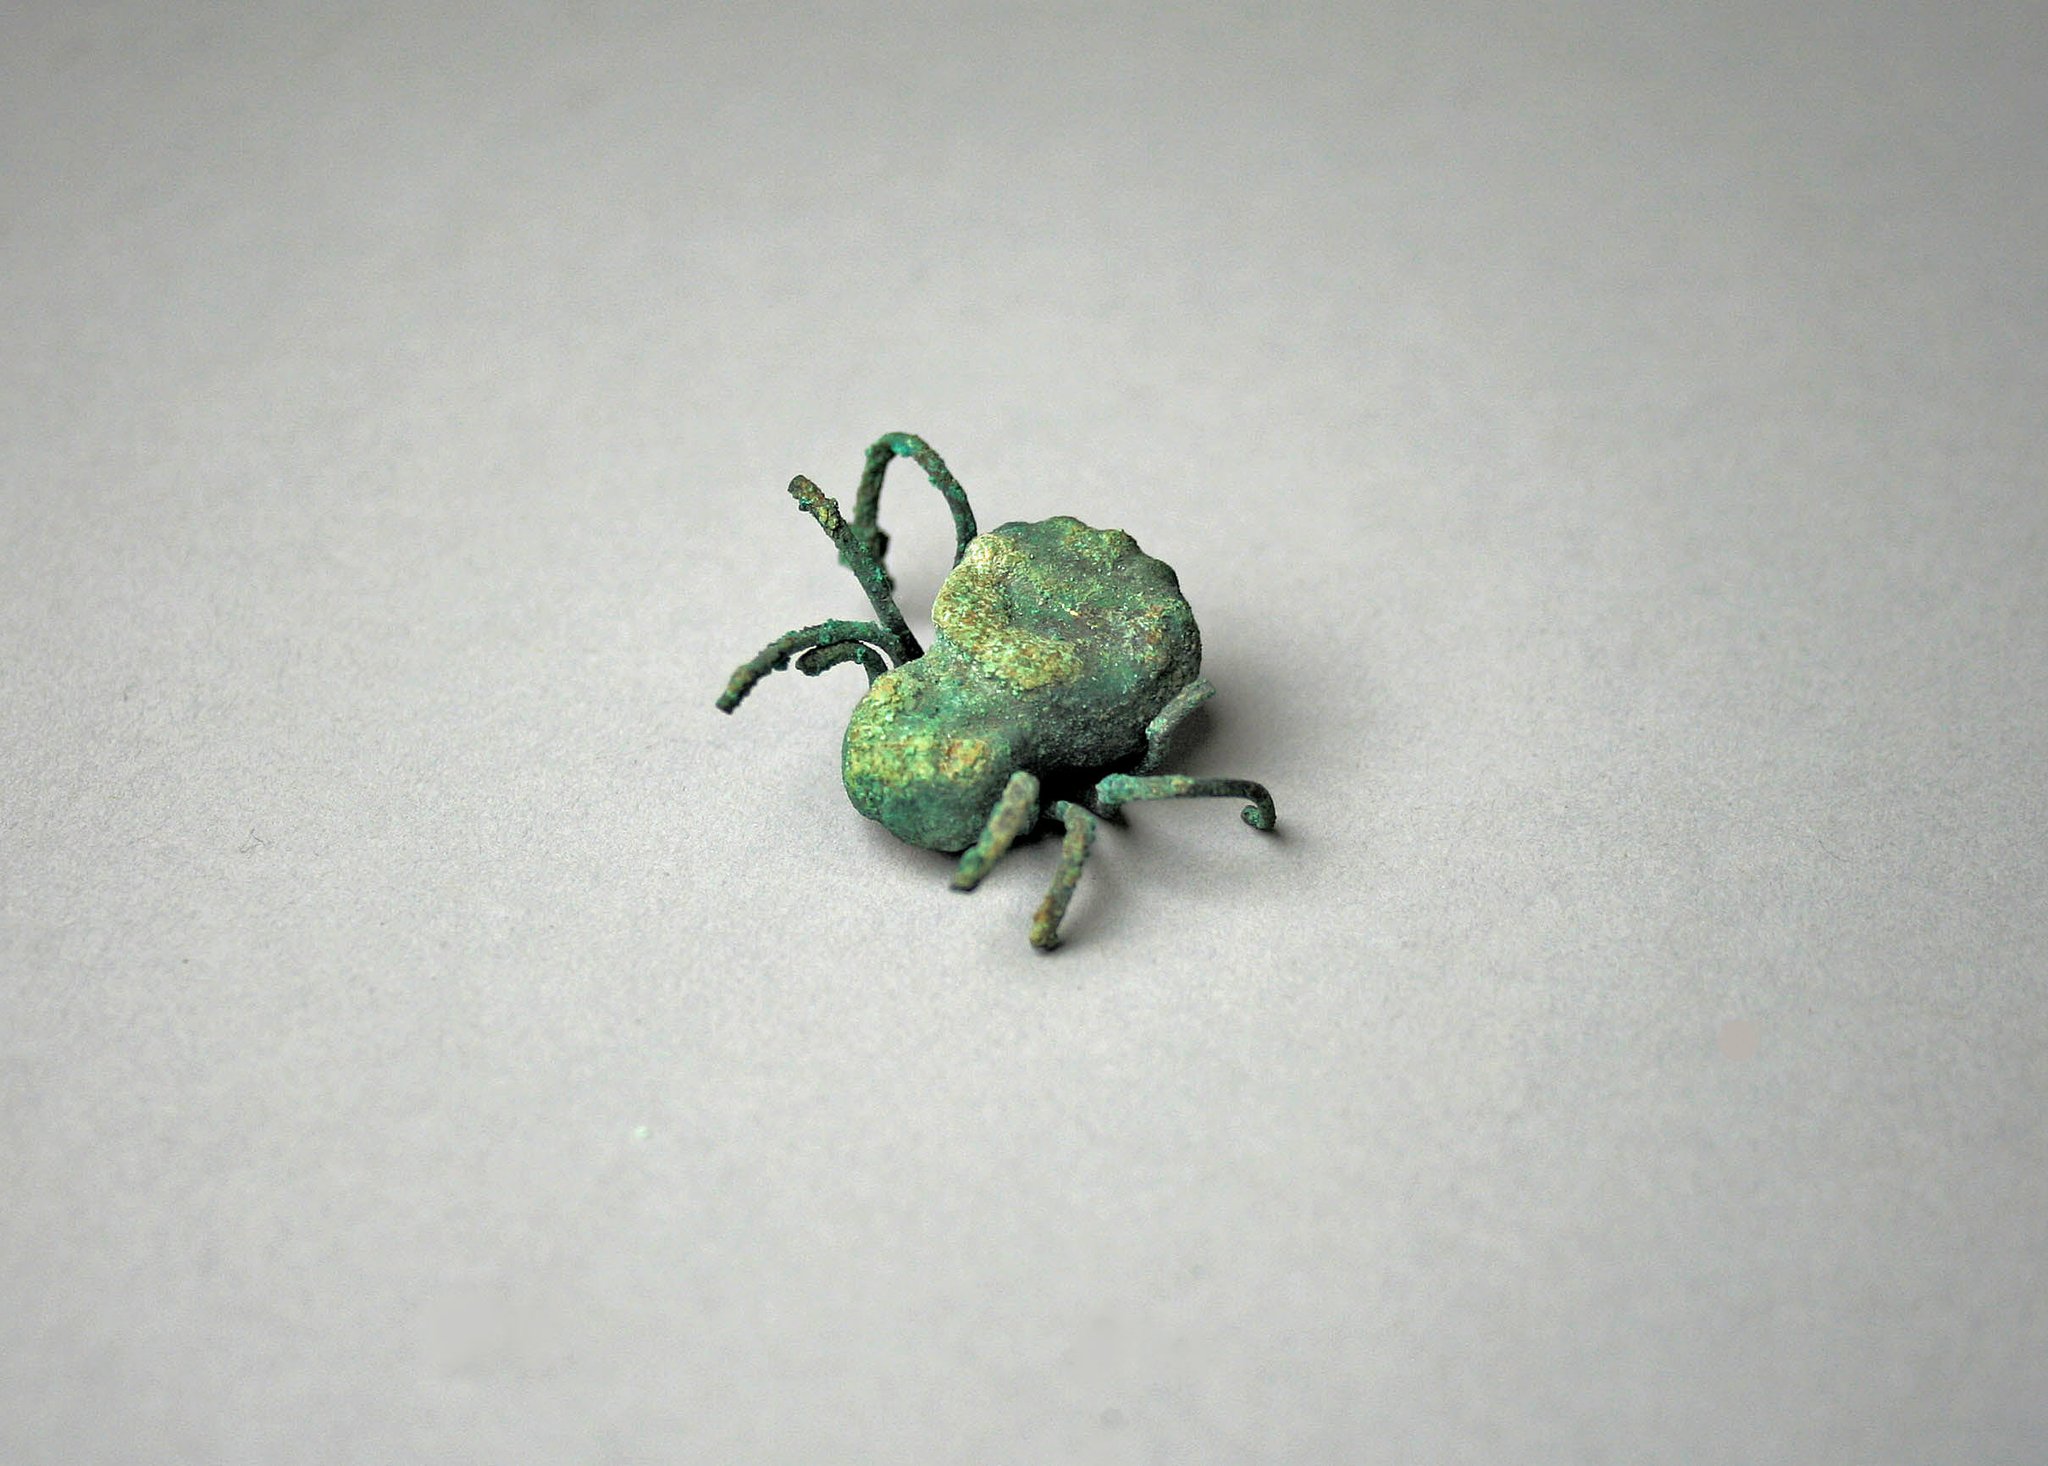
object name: ornament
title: Spider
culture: moche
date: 501-700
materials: gilt copper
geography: peru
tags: insects